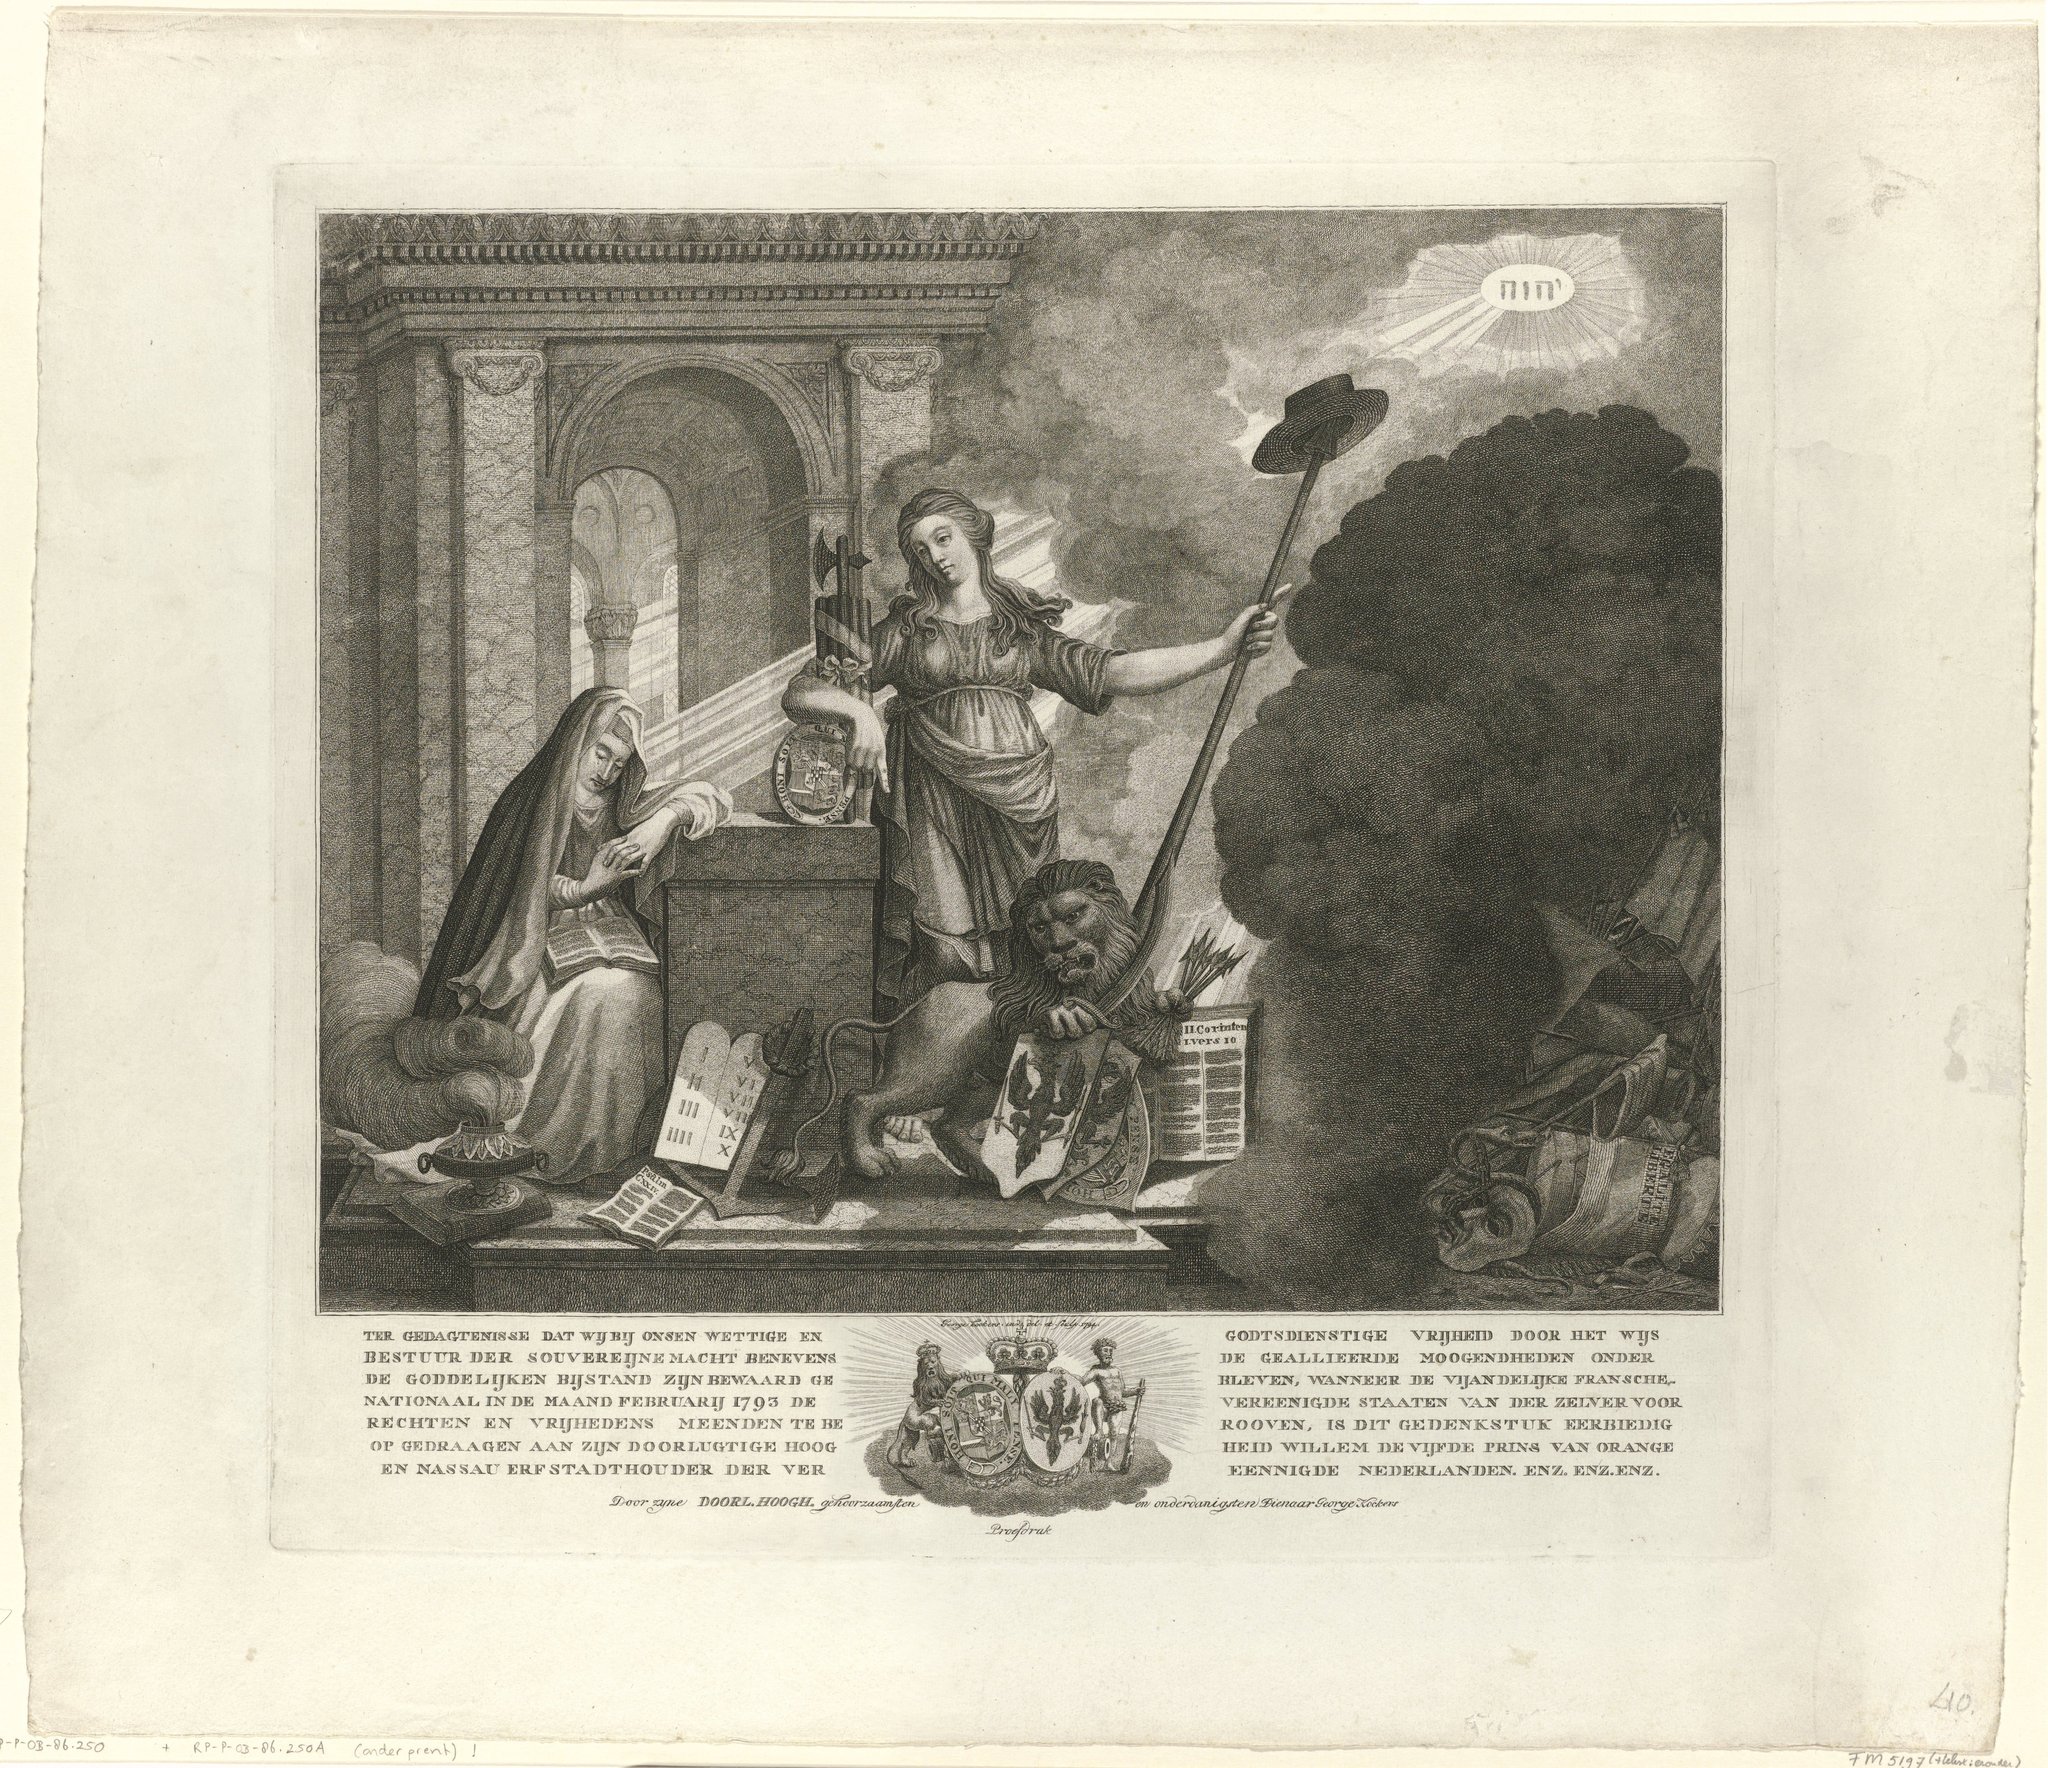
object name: text sheet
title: Verklaring van de prent met de allegorie op het behoud van de vrijheid tegenover de Franse vijand, 1793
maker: nicolaas cornel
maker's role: bookseller, printer, publisher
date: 1794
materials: paper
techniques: letterpress printing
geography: rotterdam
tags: william v (prince of orange)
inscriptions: collector's mark: Lugt 2228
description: Tekstblad met een uitleg van de voorstelling van de allegorie op het behoud van de vrijheid en godsdienst in de Republiek, dankzij de steun van God en de Coalitietroepen, door de overwinning op de Franse troepen in februari 1793. Opengevouwen blad met vier zijden genummerd 1-4.